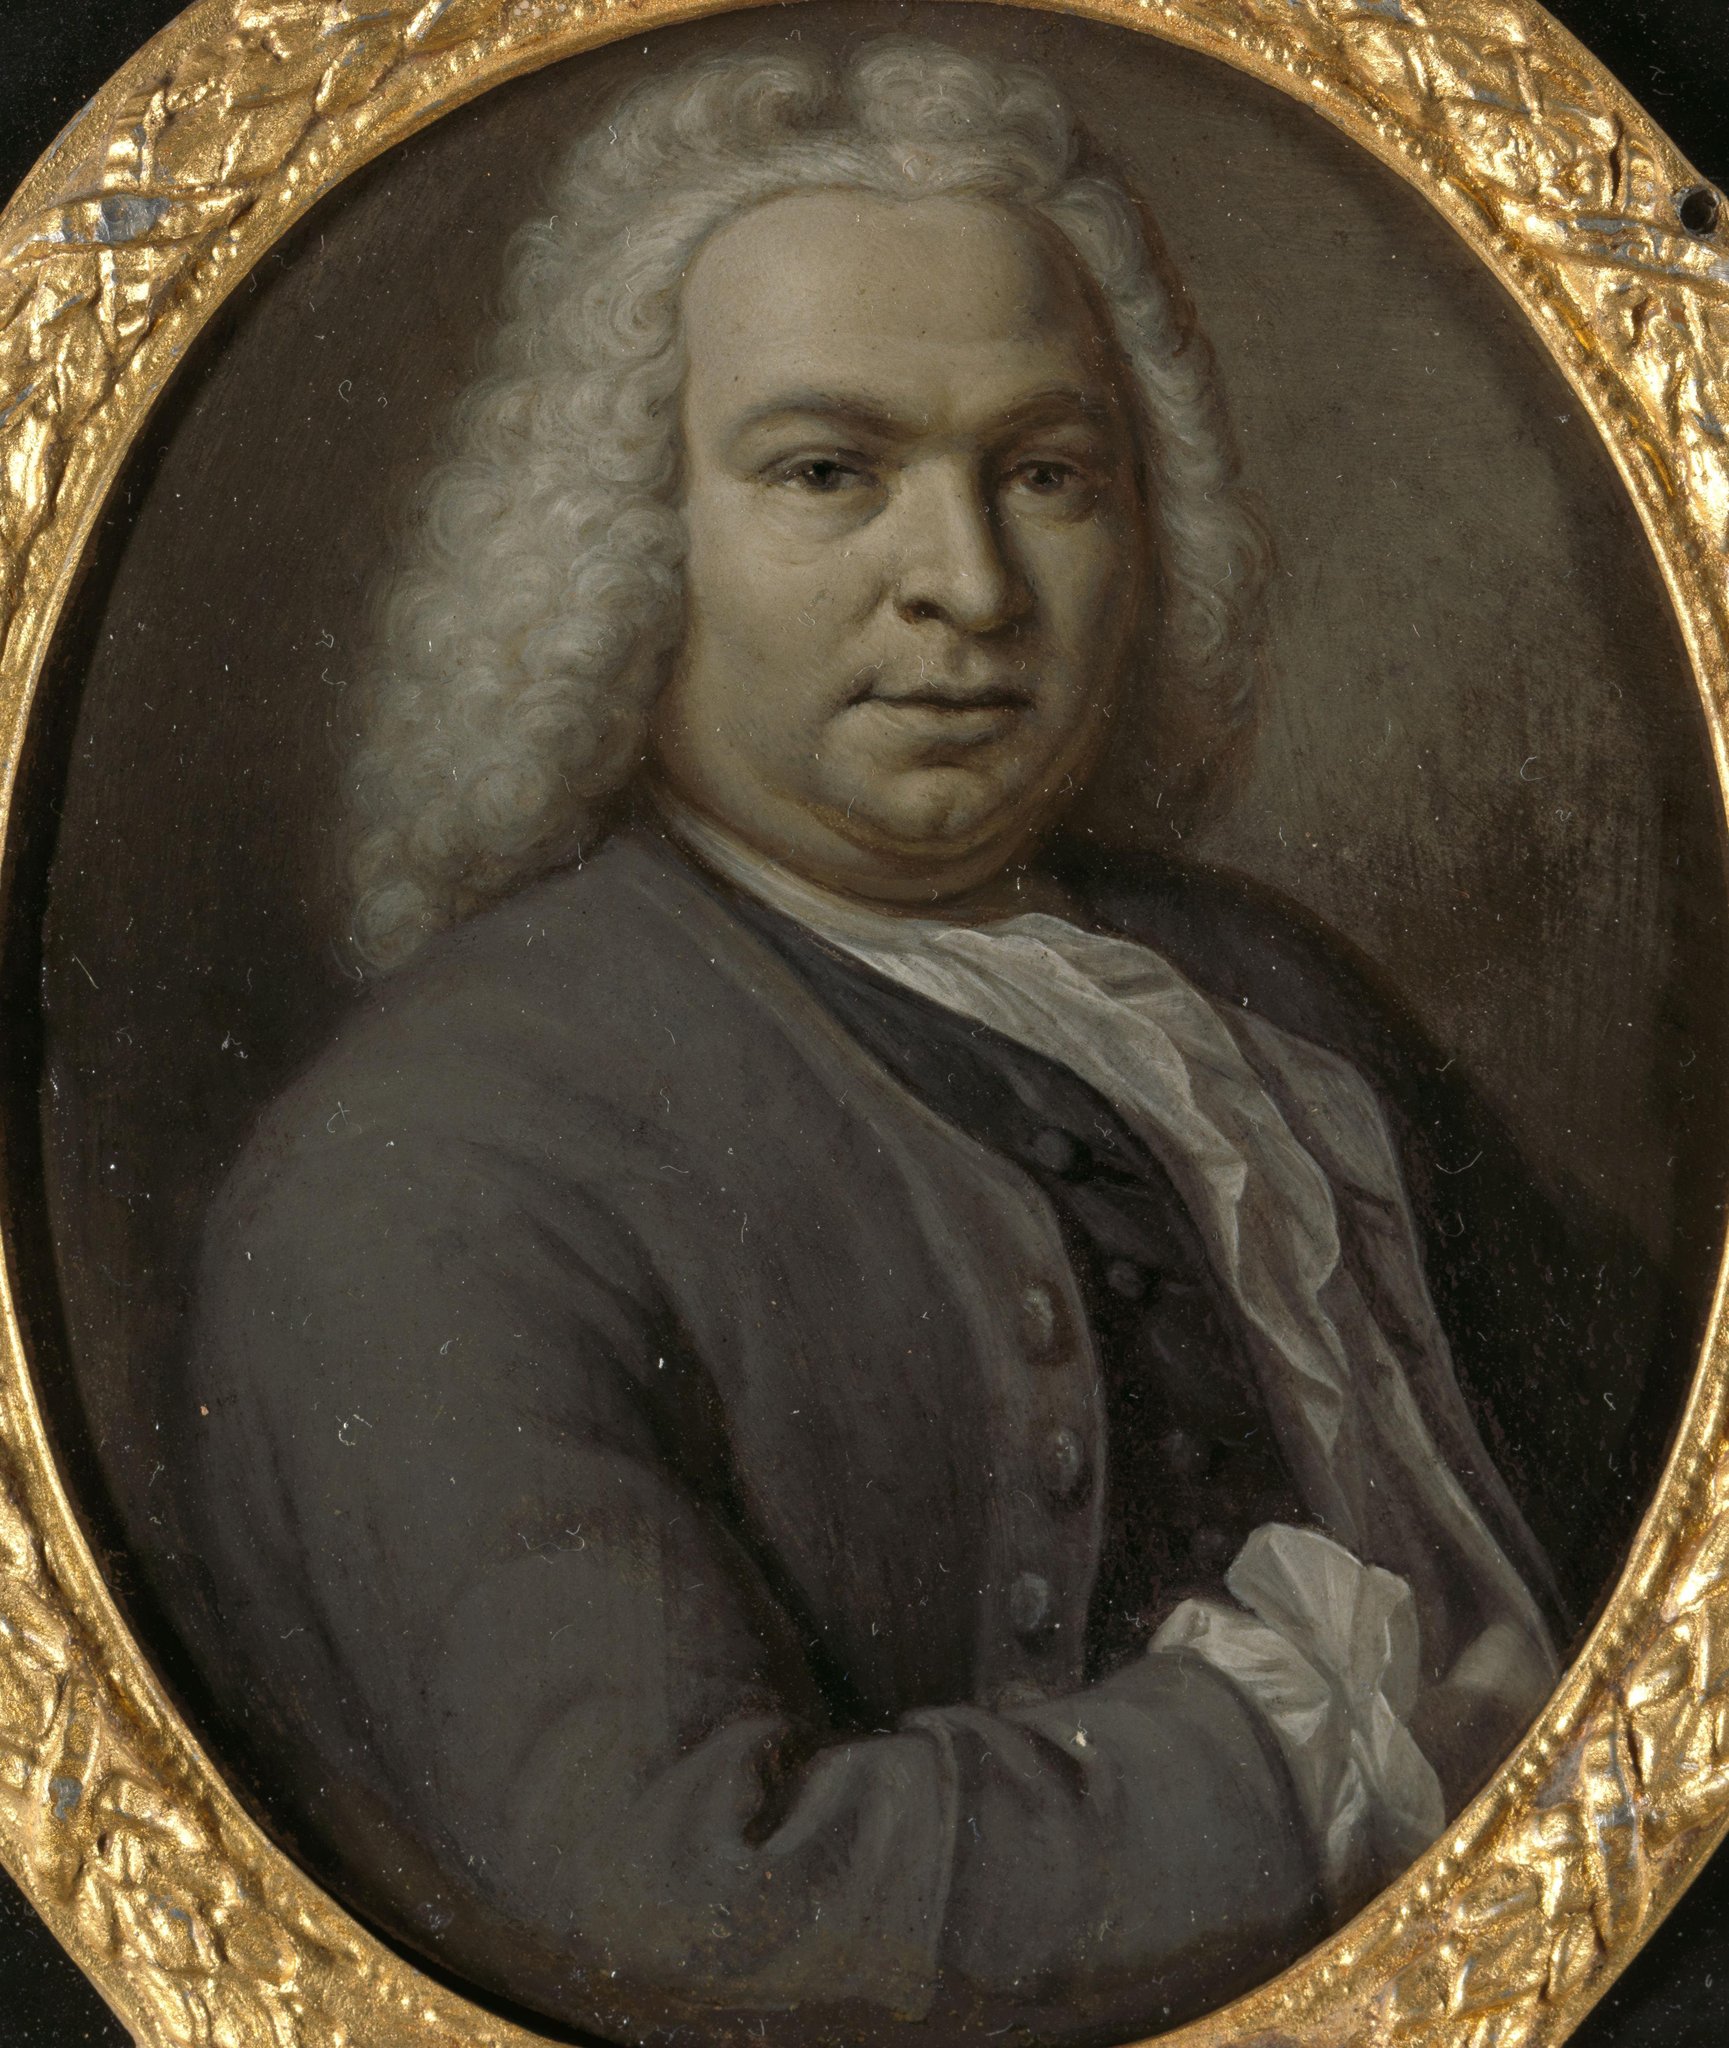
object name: painting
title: Portrait of Theodoor van Snakenburg (1695-1750). Leiden Jurist and Poet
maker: hieronymus van der mij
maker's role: painter, print maker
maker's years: 1687-1761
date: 1743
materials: copper, oil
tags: leiden, theodoor van snakenburg, portrait of a writer, writer, poet, author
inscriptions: signature, date and inscription: ‘Mr Theodoor van Snakenburg geb. te Leiden den 6 Juni Aº 1695. H: van der Mij Fec. Aº 1743’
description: Portret van Theodoor van Snakenburg (1695-1750). Rechtsgeleerde en dichter te Leiden. Buste in ovaal, naar rechts, de rechterhand in de jas gestoken. Onderdeel van een verzameling portretten van Nederlandse dichters.